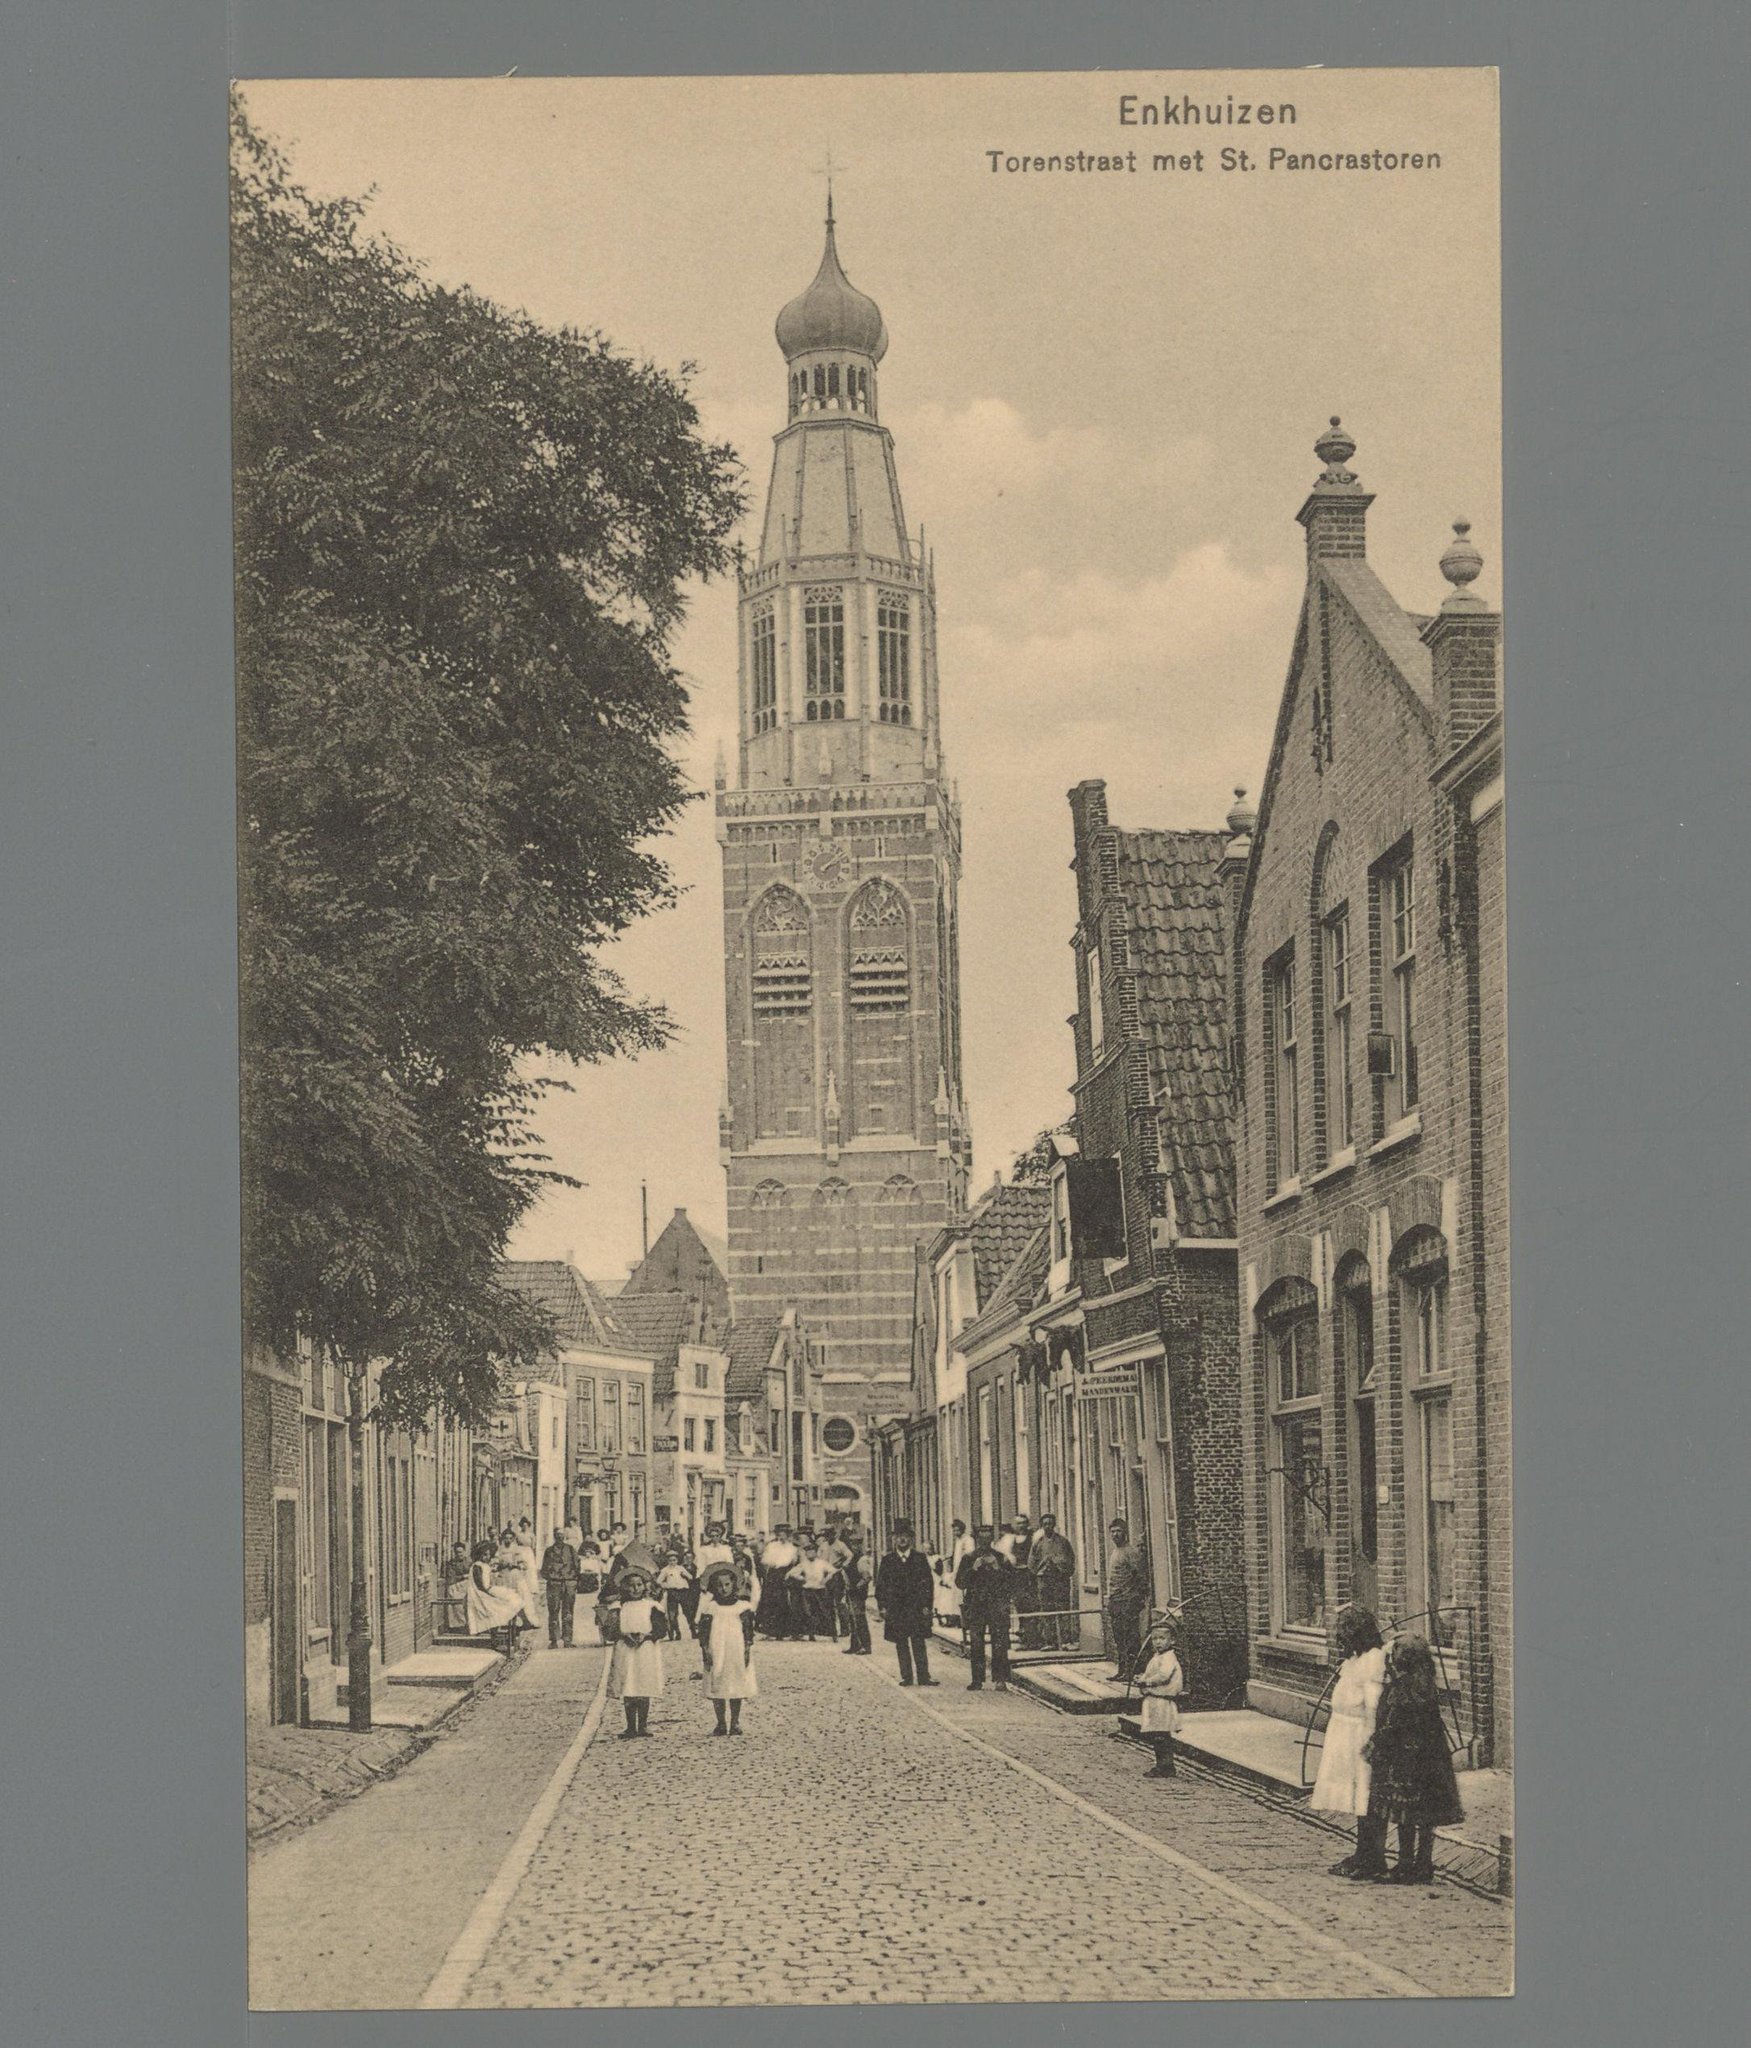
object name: photomechanical print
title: Enkhuizen. Torenstraat met St. Pancrastoren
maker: Anonymous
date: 1913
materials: cardboard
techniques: photograph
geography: the hague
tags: city-view, and landscape with man-made constructions, street, parts of church exterior and annexes: tower, enkhuizen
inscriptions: date